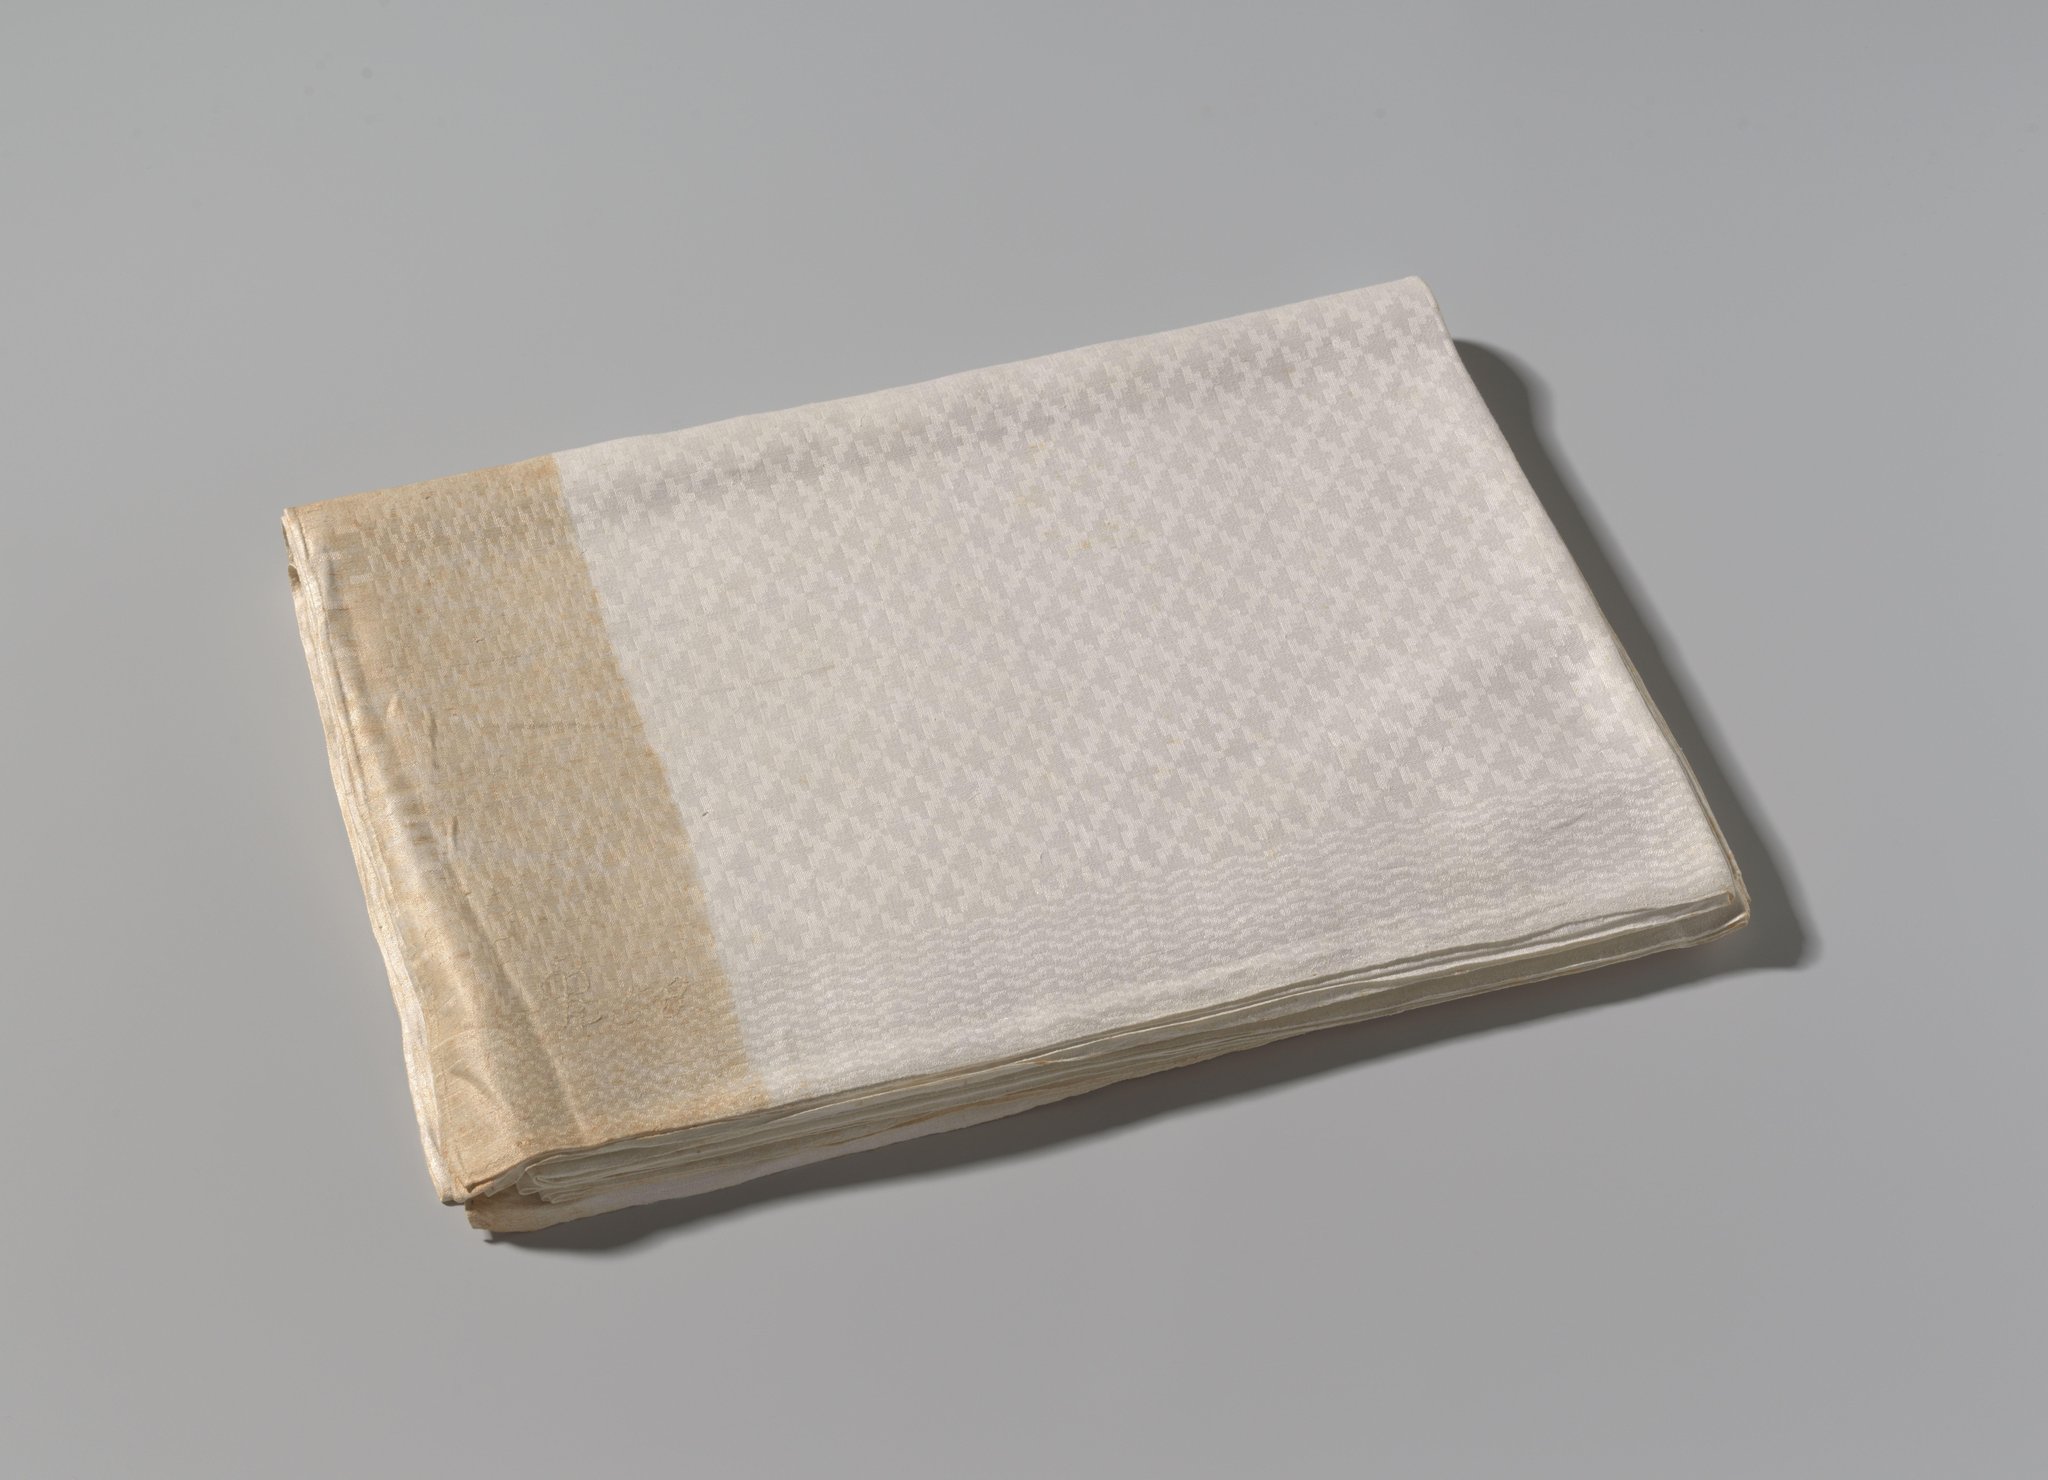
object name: tablecloth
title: Tafellaken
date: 1775-1816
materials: linen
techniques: peeled fabric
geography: netherlands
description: Wit linnen tafellaken met een pellen patroon en randen rondom, merk WS 5 en bloemetje met R aan steel 58 WH 2oonl.